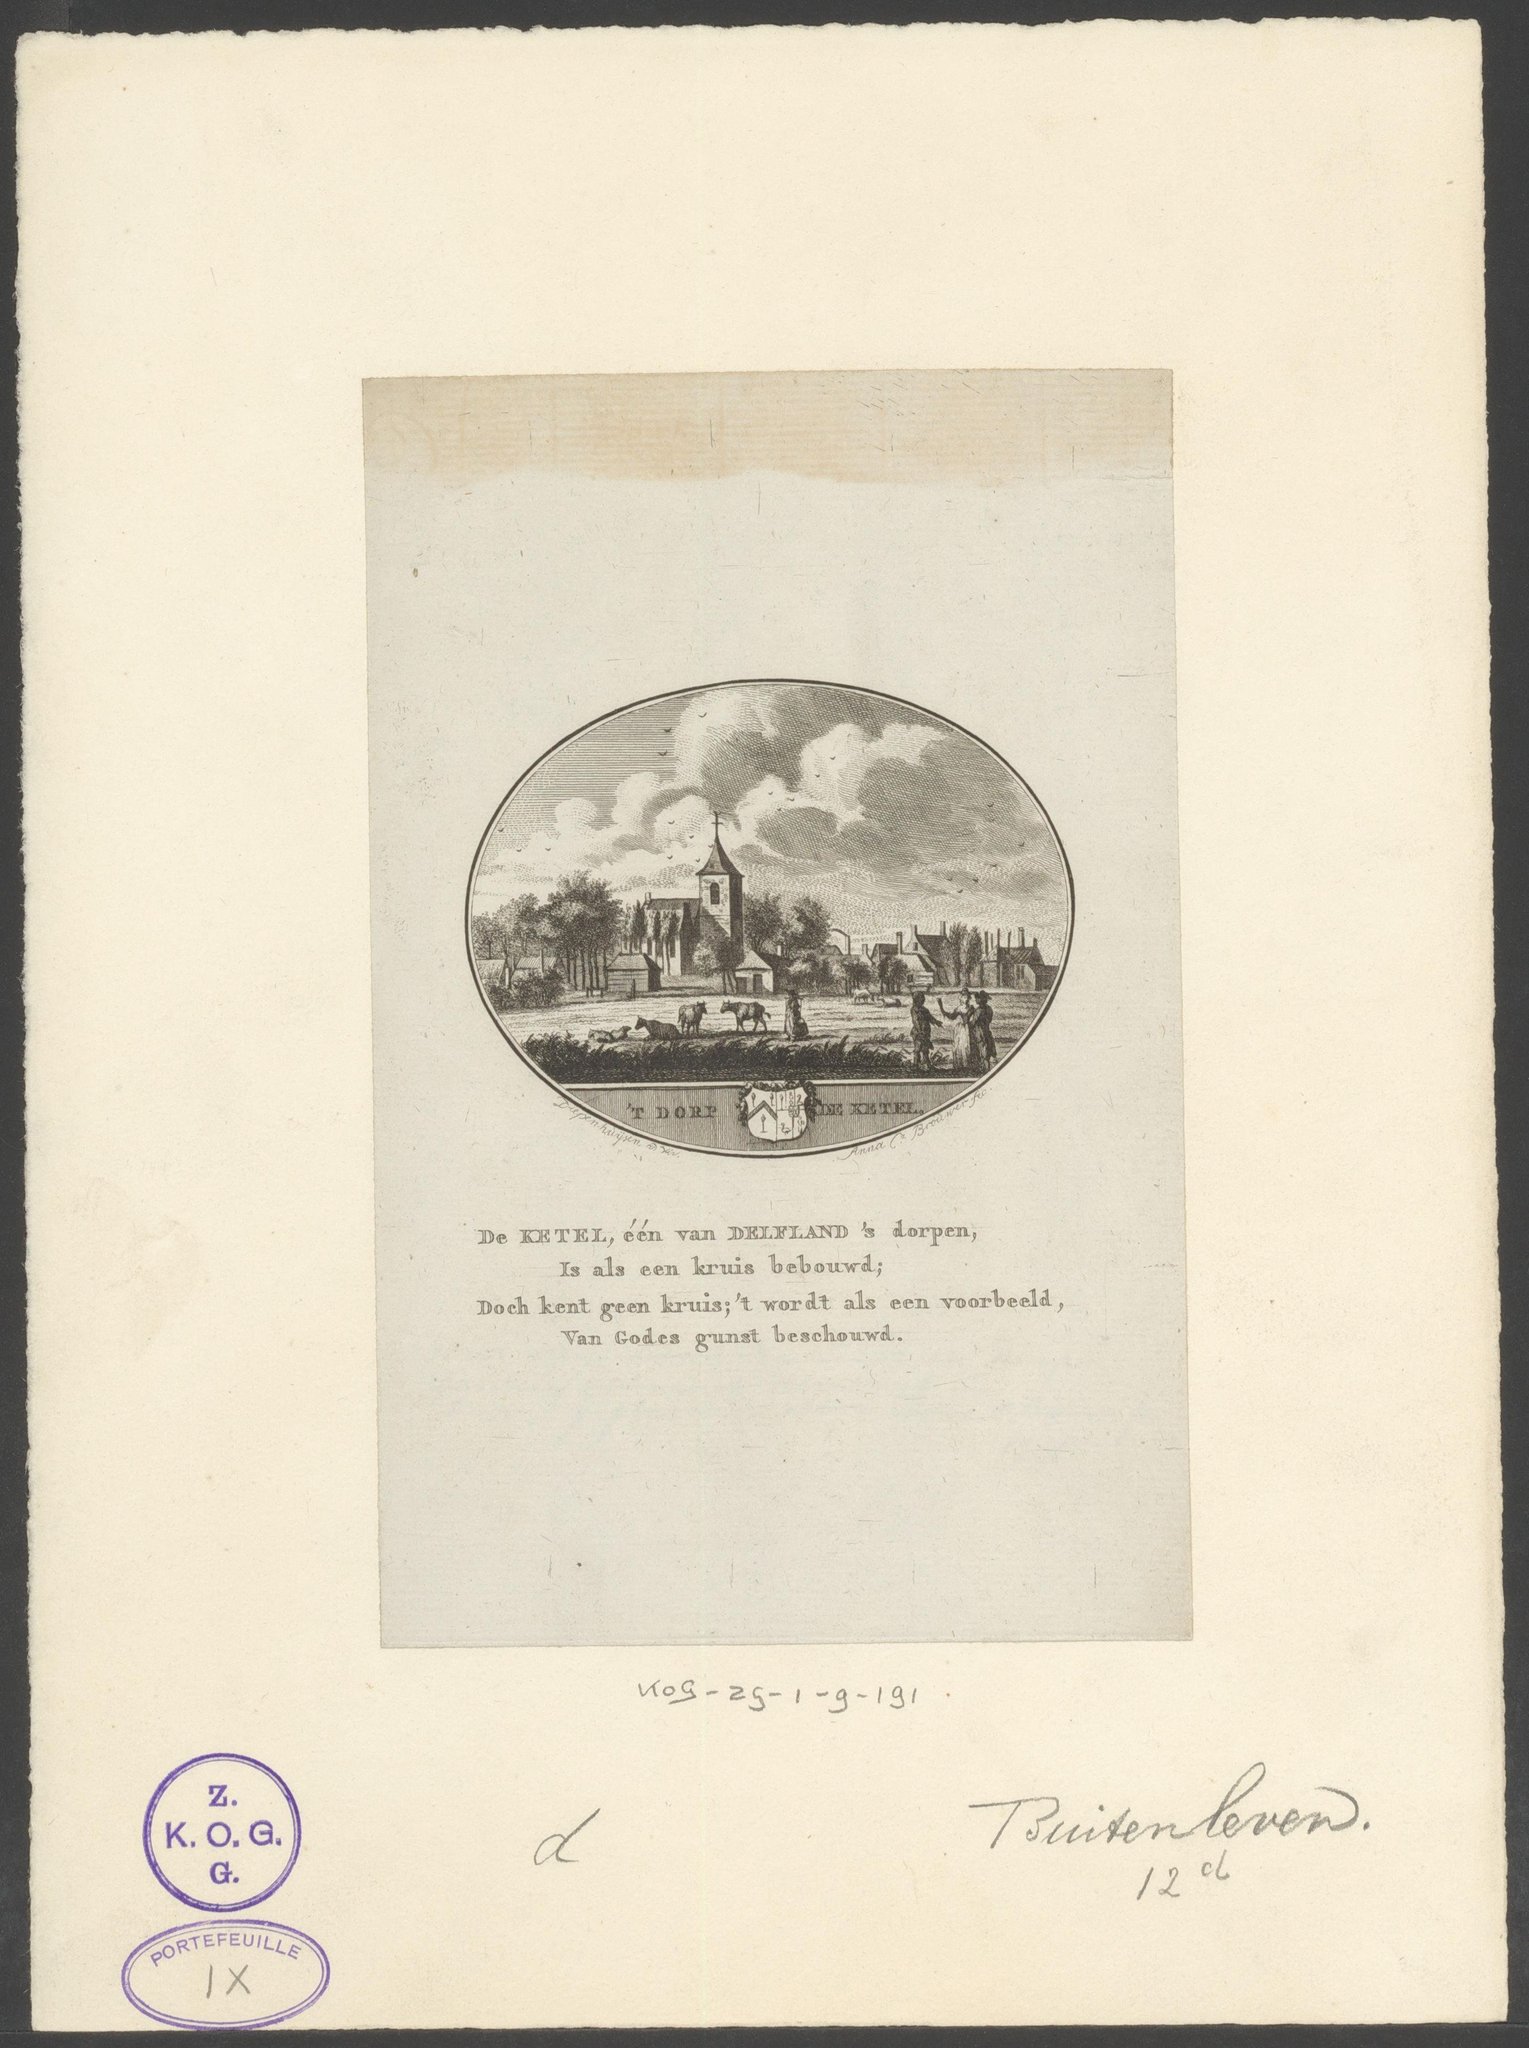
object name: print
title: 'T Dorp de Ketel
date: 1791-1793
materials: paper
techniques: etching, hand coloring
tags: city-view, and landscape with man-made constructions, church (exterior)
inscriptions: collector's mark: Lugt 1641, stamp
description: Prent waarschijnlijk uit: Ollefen, Lieve van. De Nederlandsche stad- en dorp-beschrijver. Amsterdam: Hendrik Arend Banse, 1793.